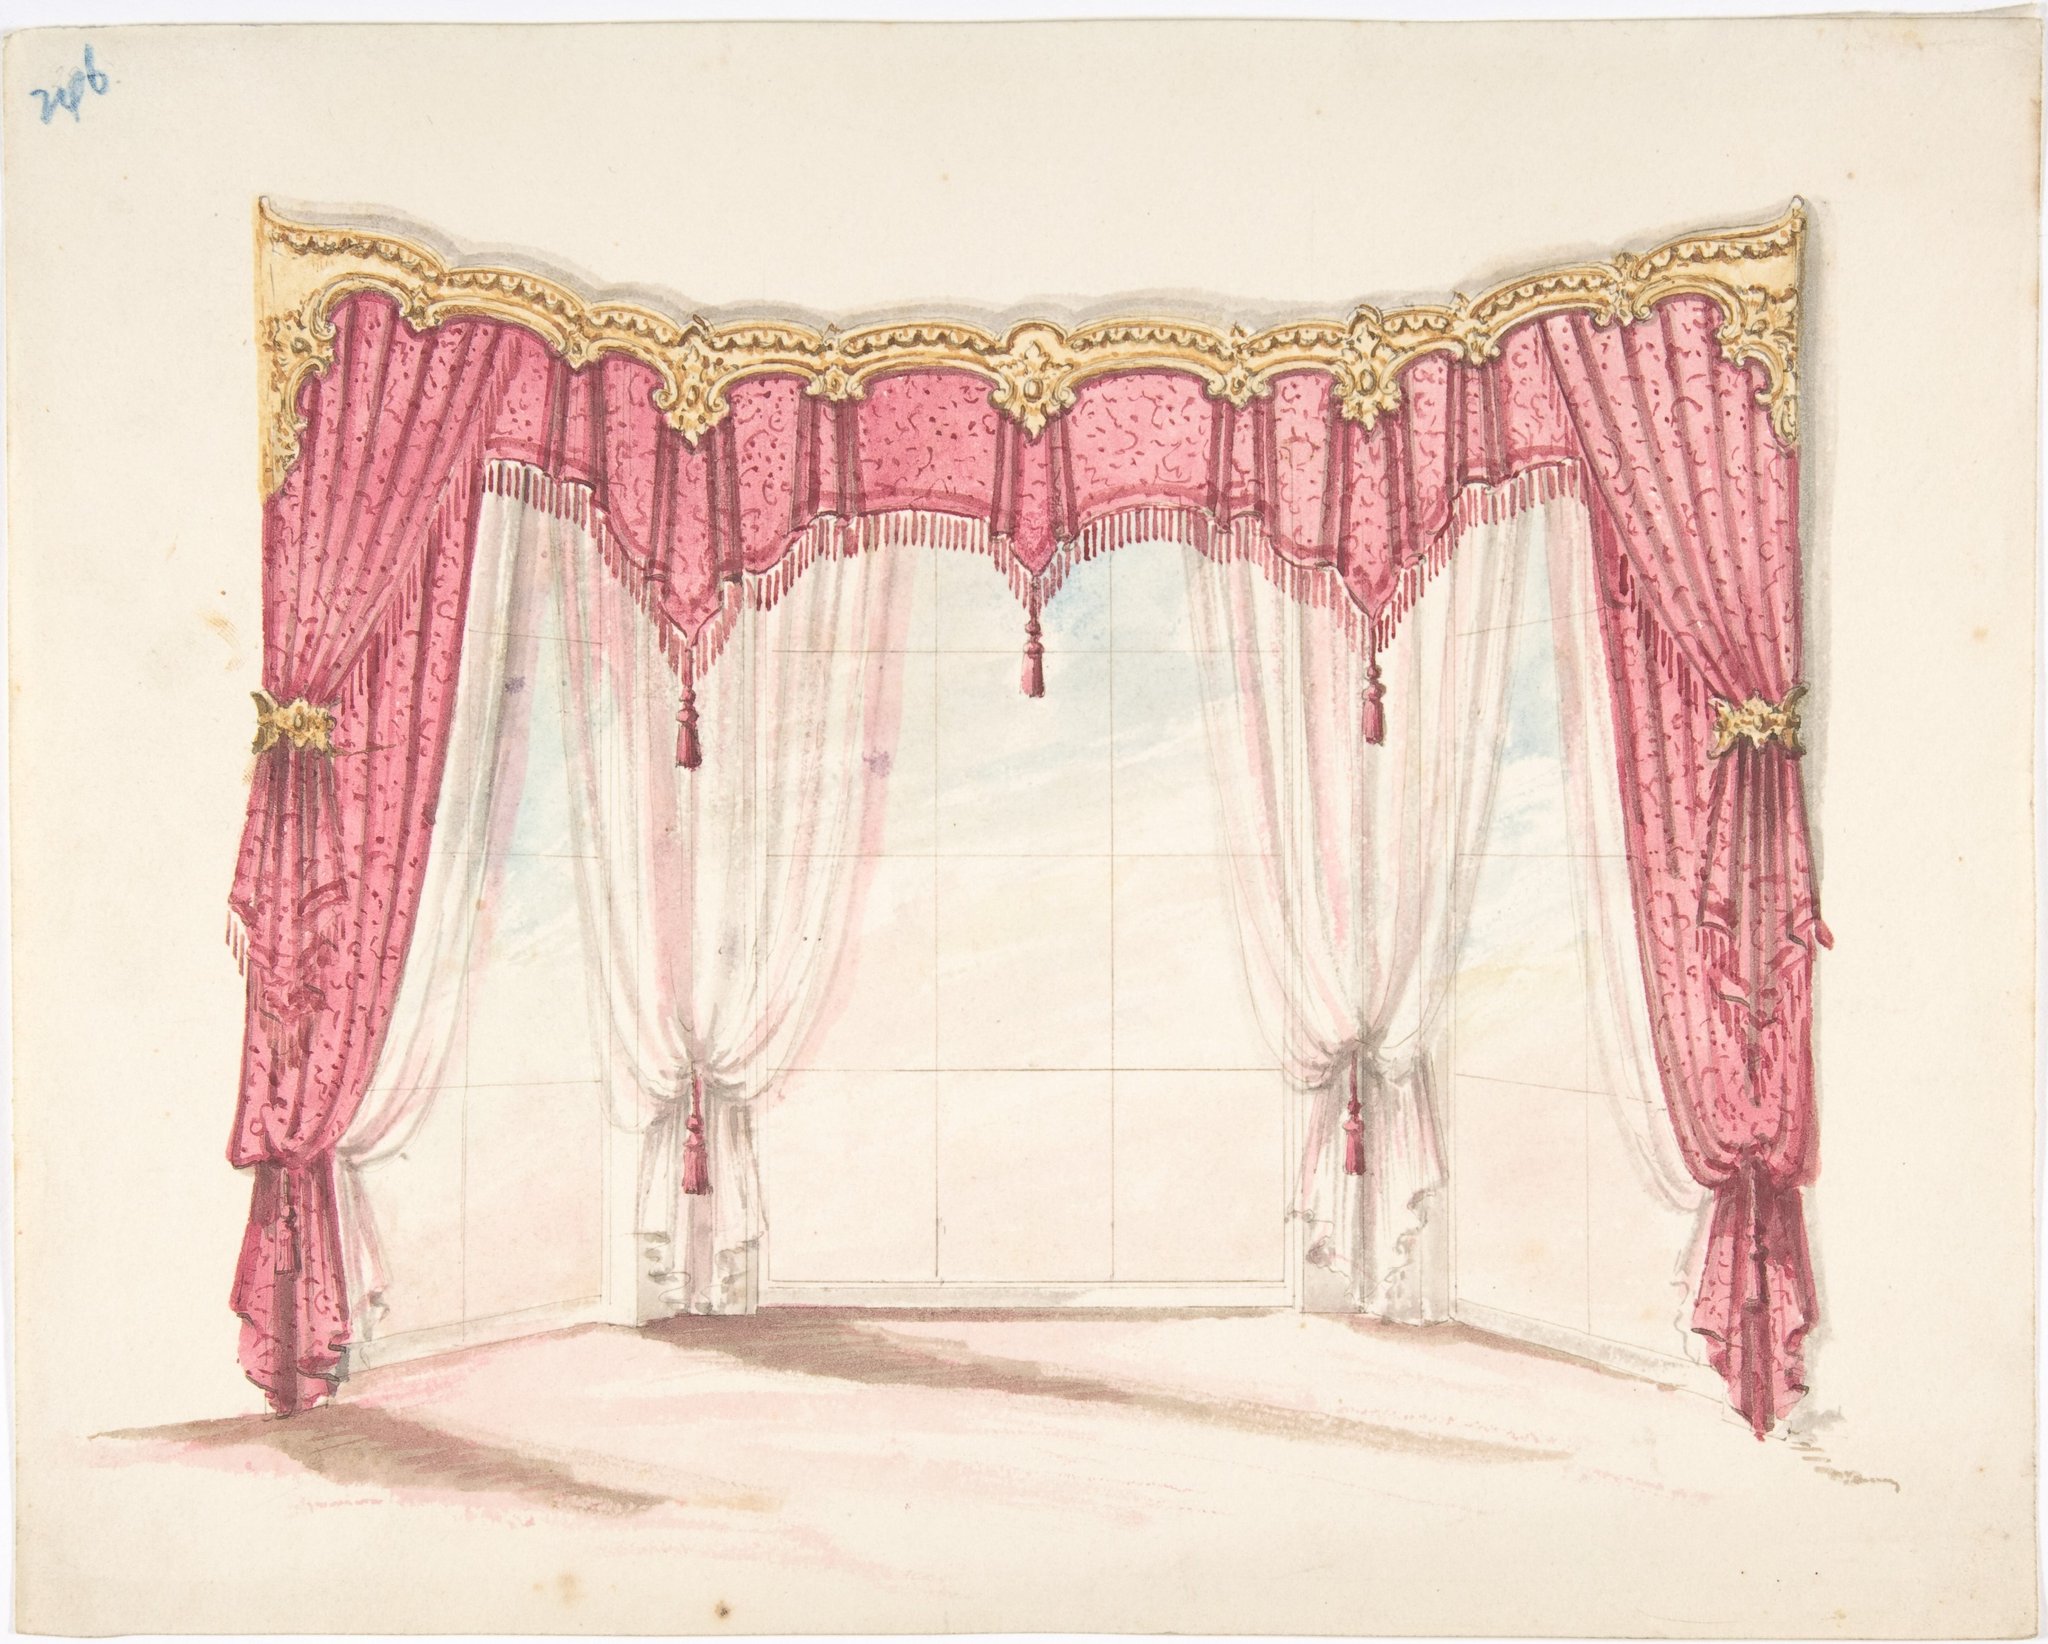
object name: drawing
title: Design for Red Fringed and Tasseled Curtains with a Gold Pelmet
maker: anonymous, british, 19th century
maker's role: artist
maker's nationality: british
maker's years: 1800-1900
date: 1801-1833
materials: ink, watercolor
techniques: brush, pen, wash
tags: windows,curtains